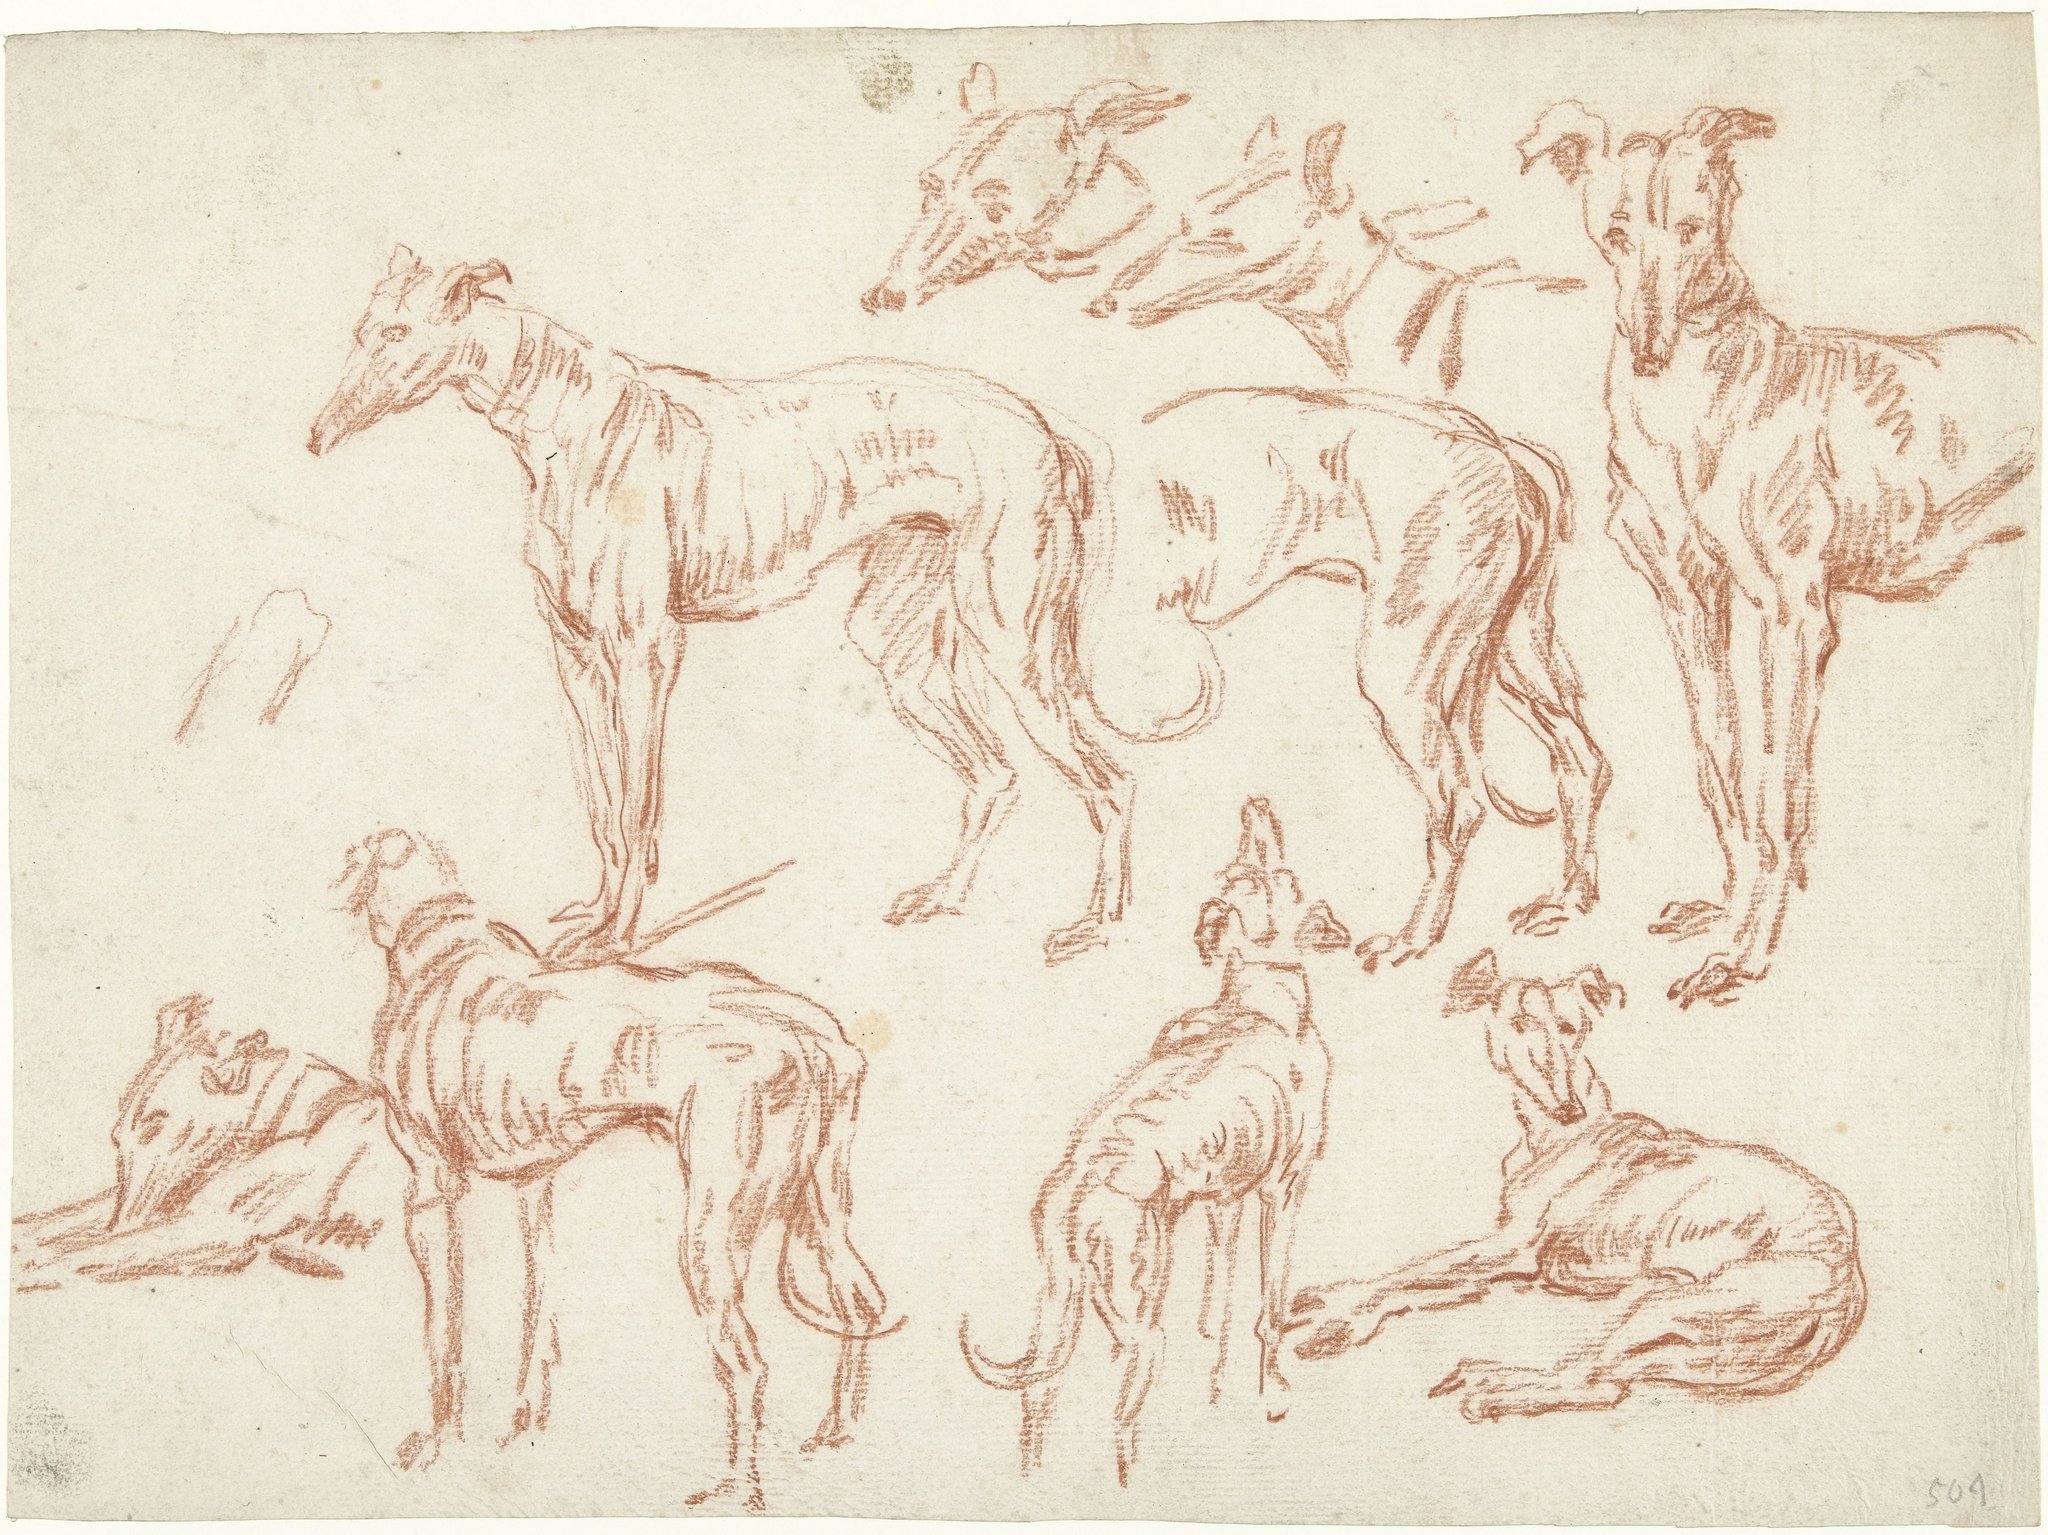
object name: drawing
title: Negen studies van een hazewindhond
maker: Anonymous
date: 1700-1721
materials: chalk, paper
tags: dog (with name of kind)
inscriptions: annotation, verso, lower right, pencil: ‘F. Snijders’, collector's mark: Lugt 2228a, annotation, recto, lower right, pencil: ‘504’